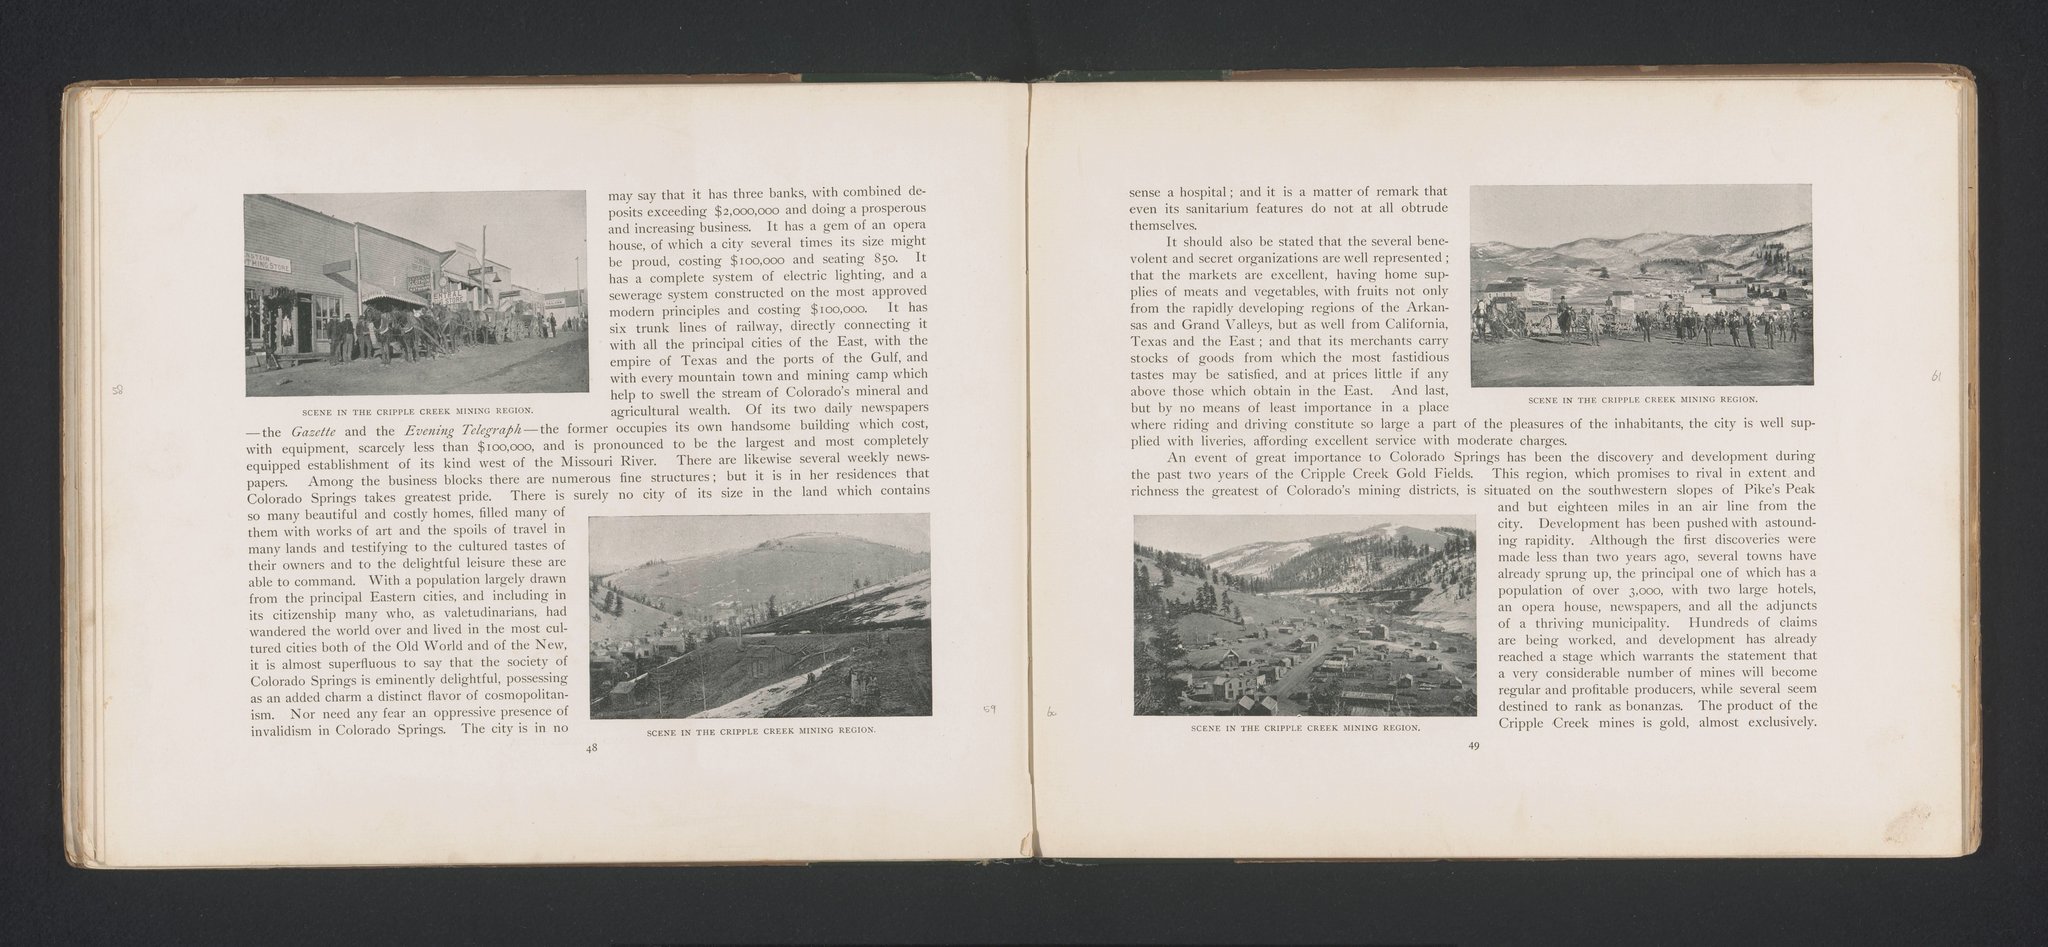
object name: page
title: Scene in the Cripple Creek mining region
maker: Anonymous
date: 1888-1893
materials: paper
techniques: autotype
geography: new york city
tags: four-wheeled vehicle drawn by more than three animals, street